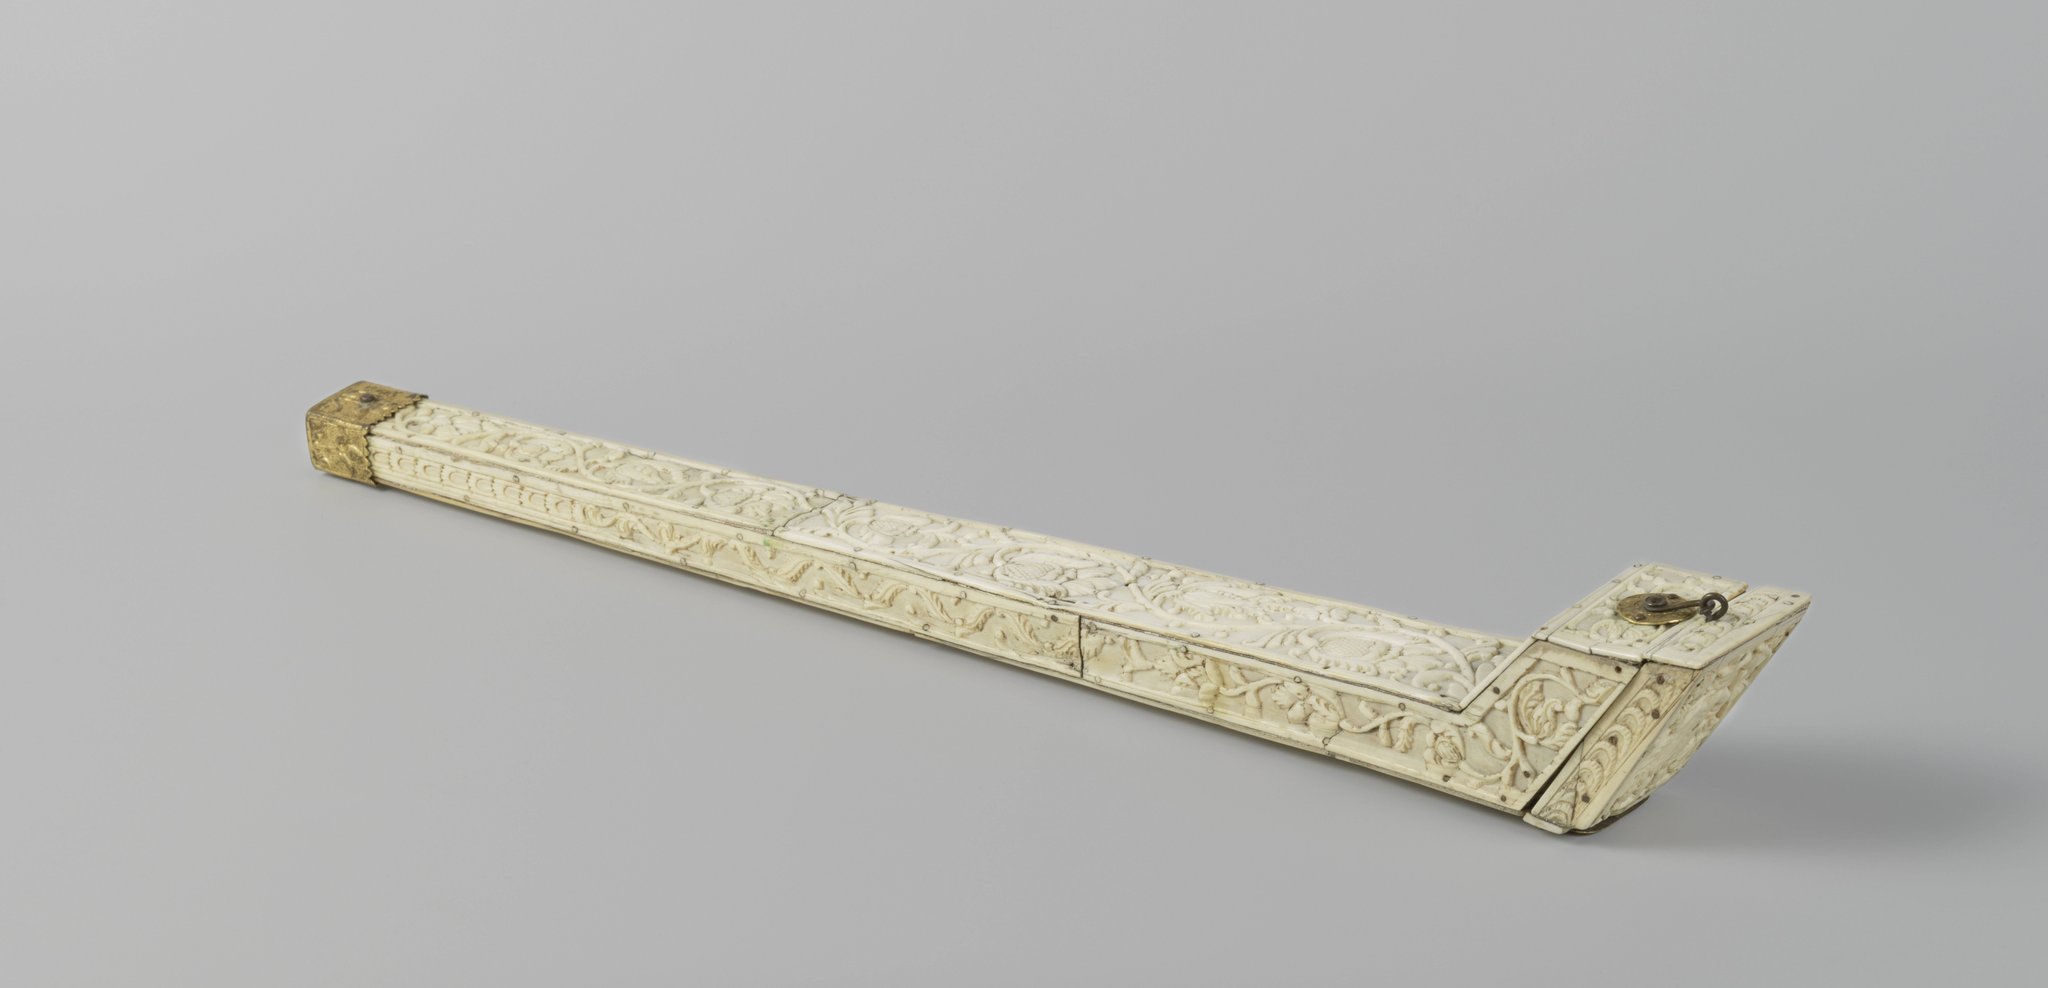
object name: pipe holder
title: Case for a pipe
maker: Anonymous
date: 1700-1725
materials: copper, ivory, metal, wood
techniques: cutting, gilding, striking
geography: sri lanka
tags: foliage, tendrils, branches ~ ornament, sri lanka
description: Long-stemmed Gouda pipes were very popular with the Dutch, including those living in the tropics. Since the clay pipes were fragile, protective cases for them were not an undue luxury. This ivory case from Ceylon is ornamented with flowering branches, a decoration that found great favour among Europeans. On the short end of the lid is a pipe-smoking Dutchman.